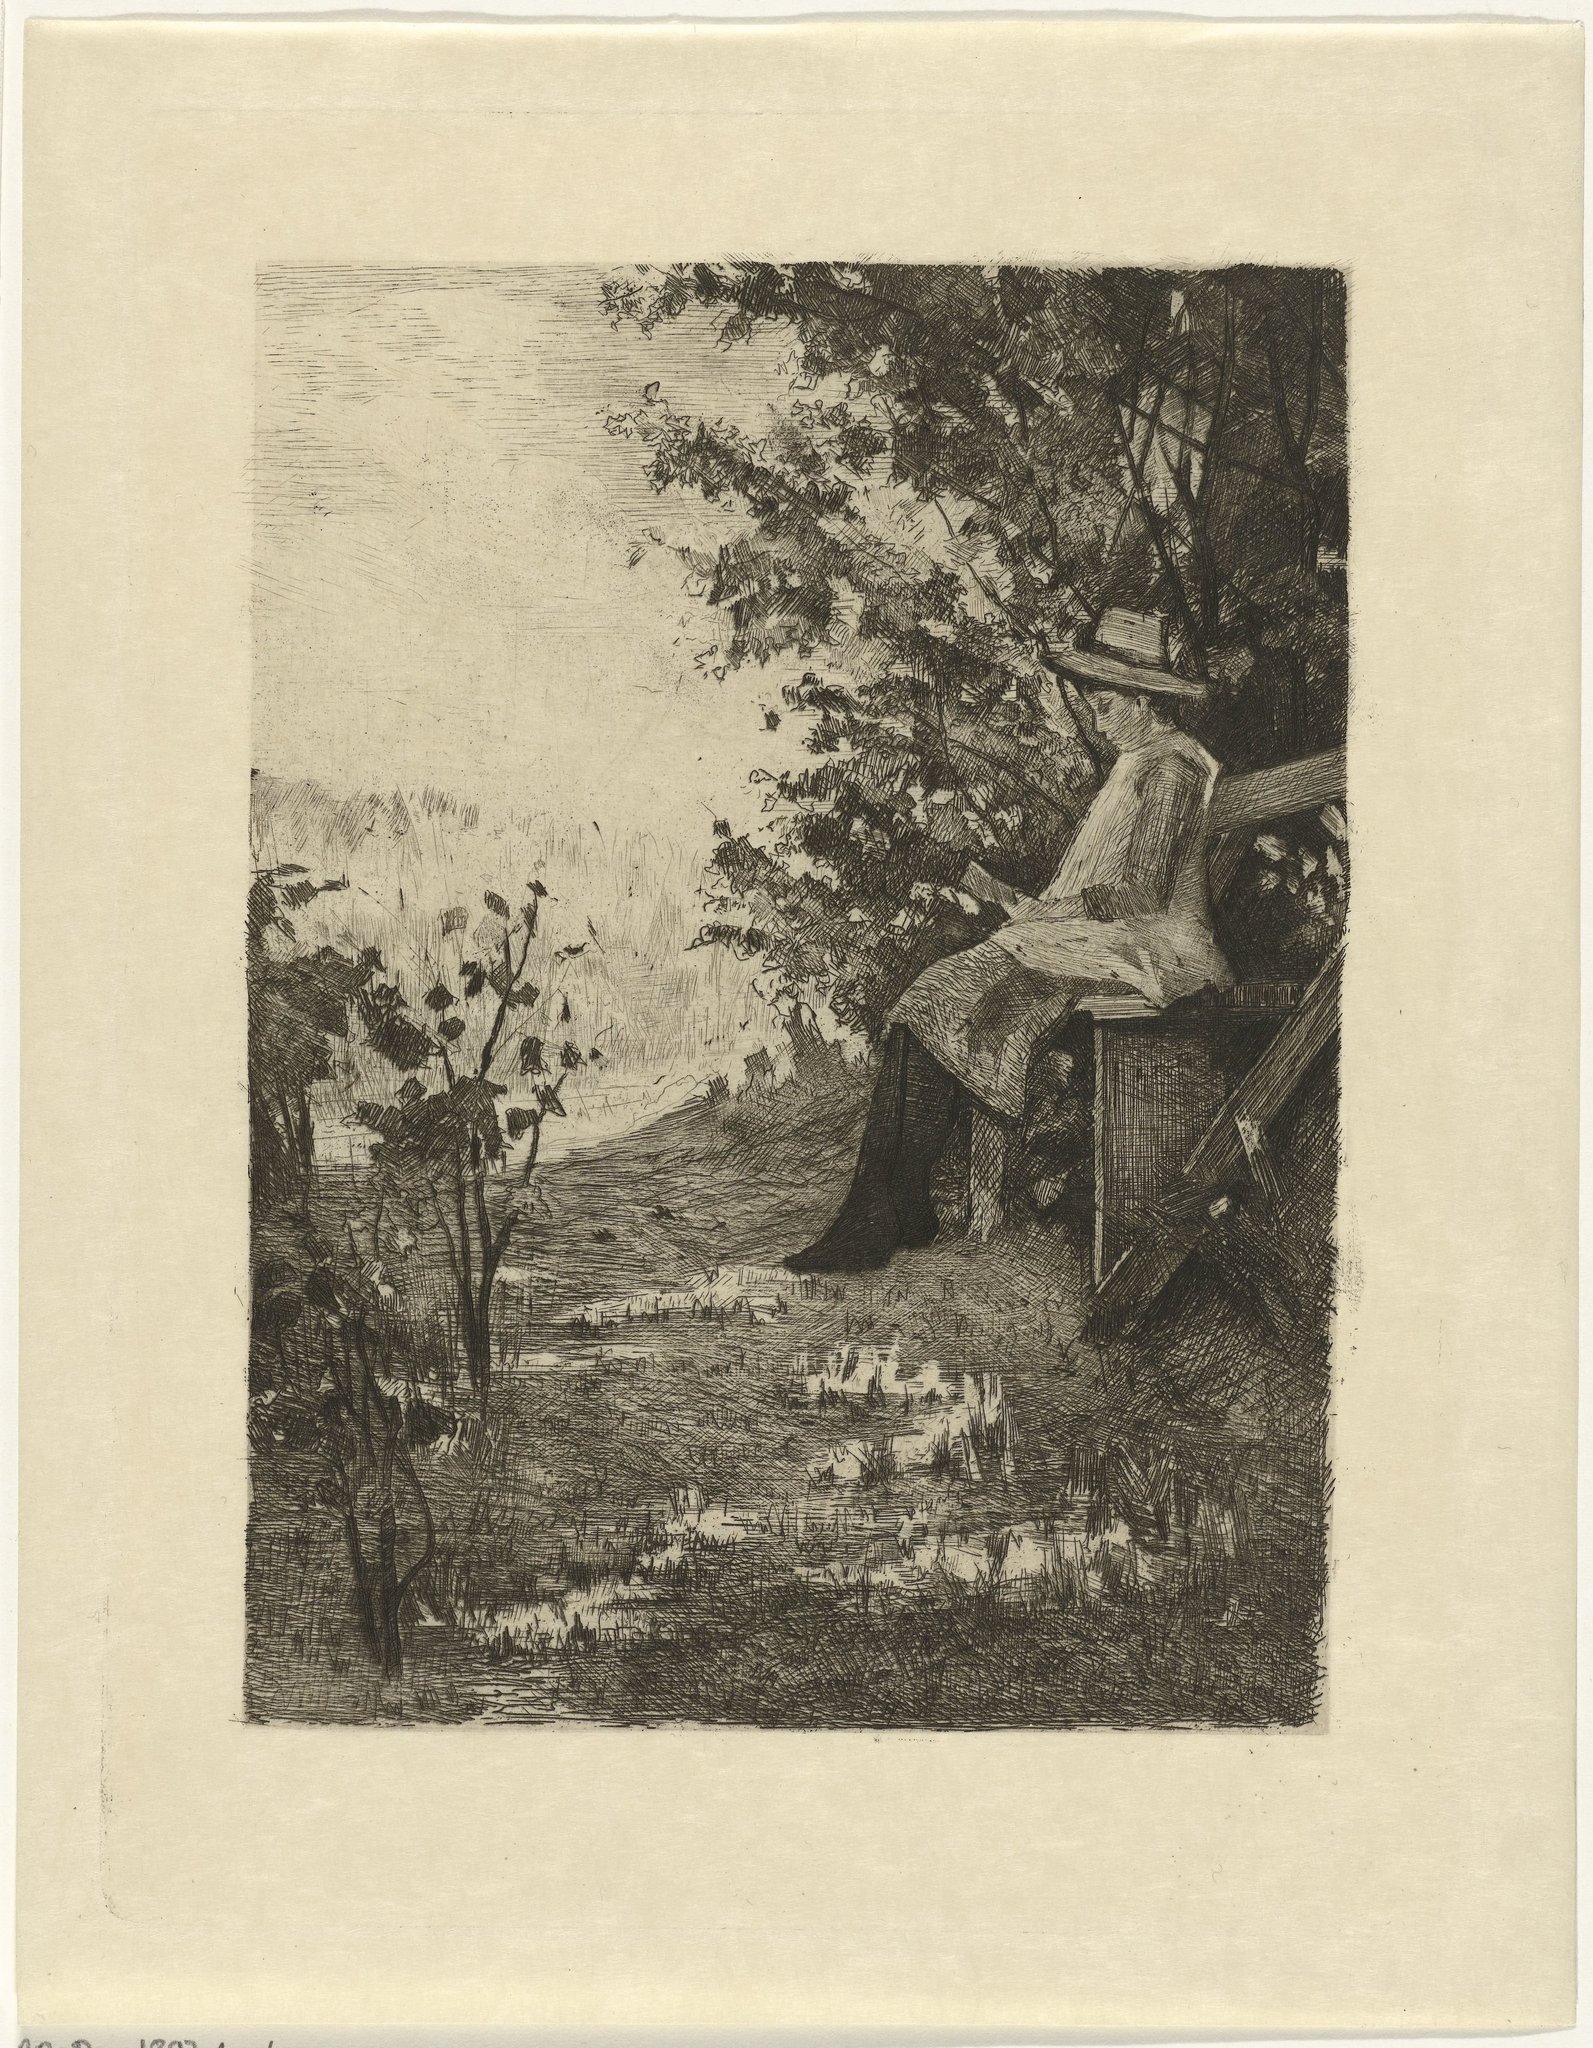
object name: print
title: Lezend jongetje op een bank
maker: ferdinand oldewelt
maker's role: draughtsman, print maker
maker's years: 1857-1935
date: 1872-1897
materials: paper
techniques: drypoint, etching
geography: netherlands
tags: reading, boy (child between toddler and youth)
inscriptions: collector's mark: Lugt 2228